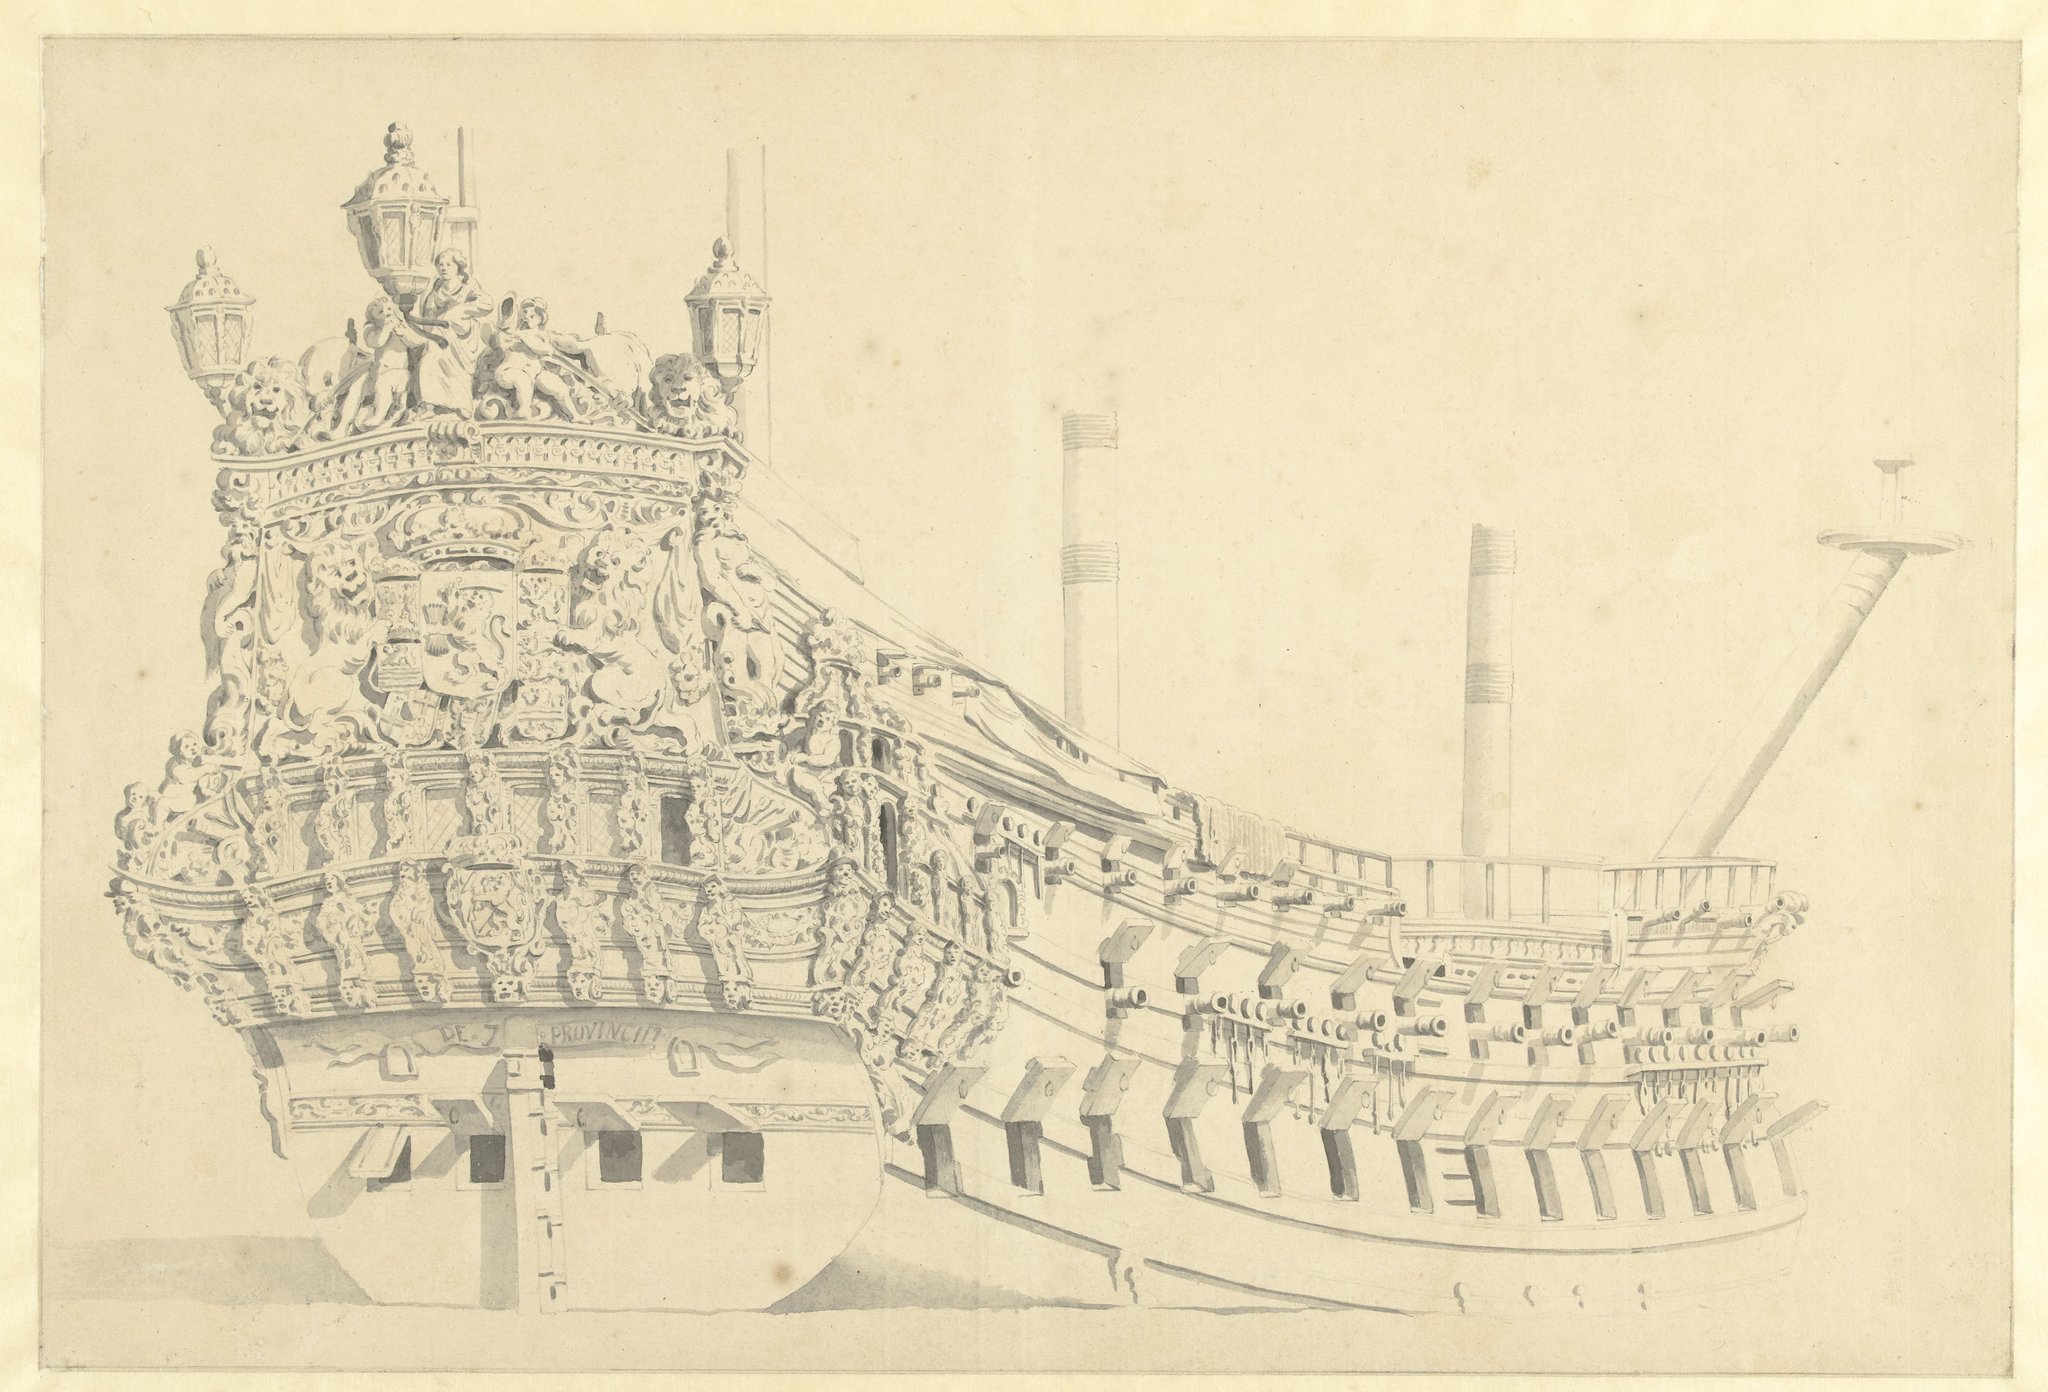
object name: drawing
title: Spiegel van het schip de Zeven Provinciën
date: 1665-1707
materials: paper, pencil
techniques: brush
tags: sailing-ship, sailing-boat, names of artefacts and man-made objects (buildings excluded), navy (+ sailing-ships)